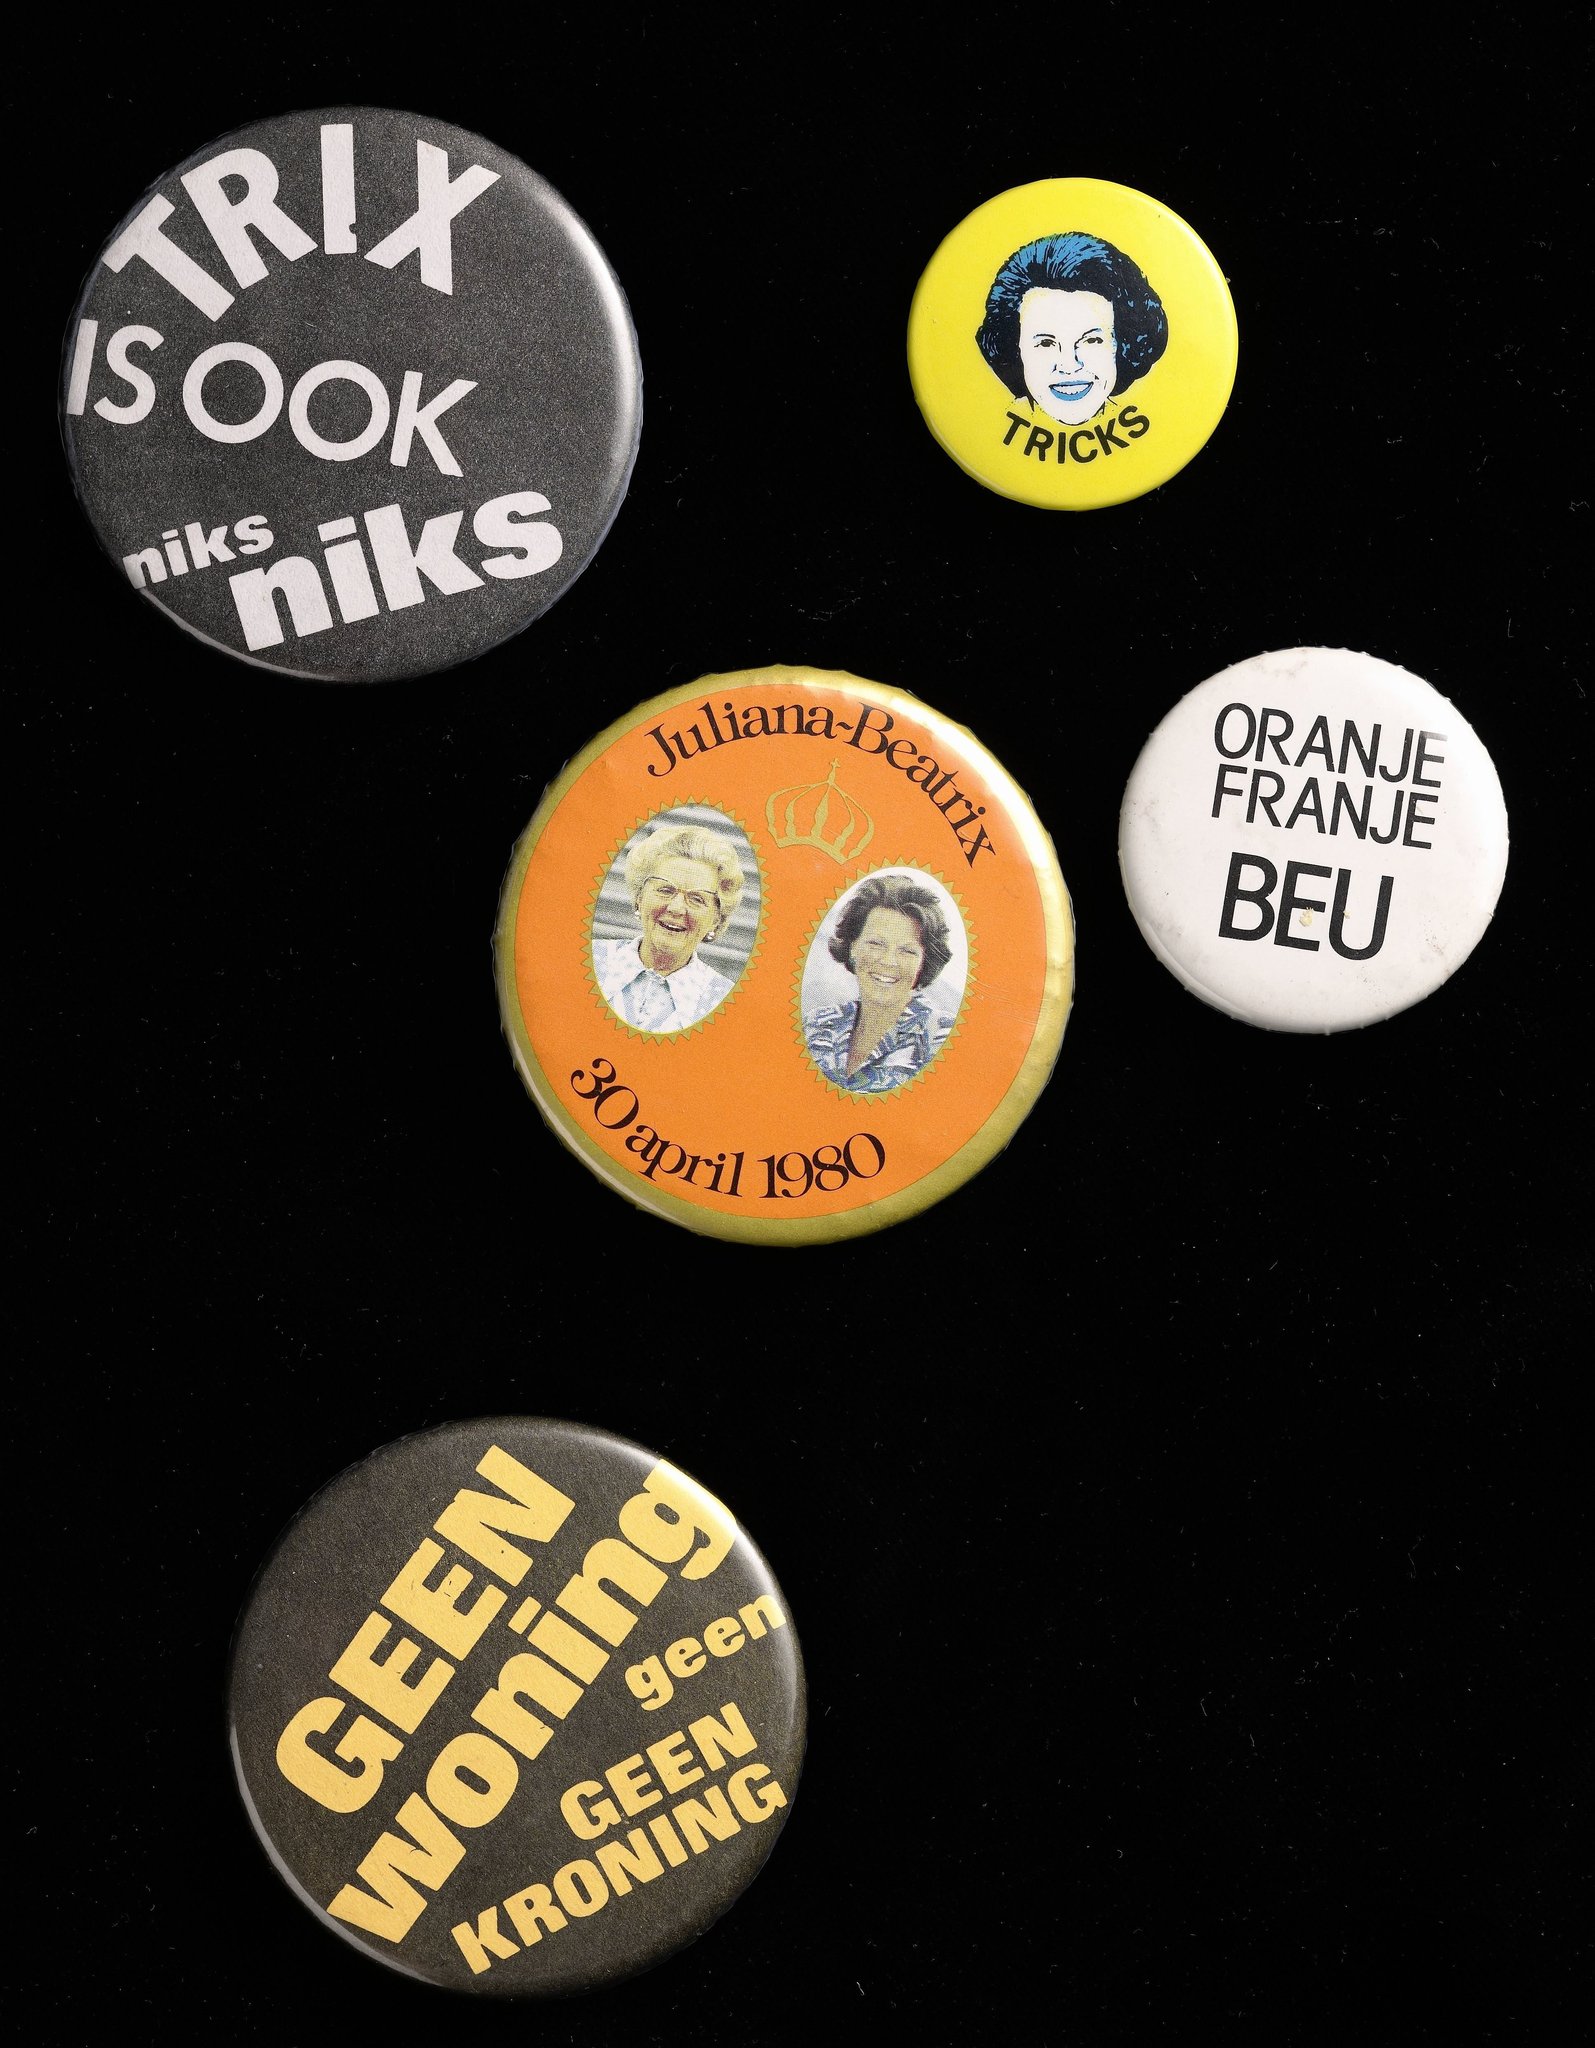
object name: button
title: Button met als tekst: Oranje franje beu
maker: Anonymous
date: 1980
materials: copper, metal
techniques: printing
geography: netherlands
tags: beatrix (koningin der nederlanden), the hague, juliana of the netherlands, netherlands, inauguration of beatrix as queen of the netherlands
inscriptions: inscription: ‘ORANJE FRANJE BEU’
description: Witte button met zwarte tekst. Achterzijde button is voorzien van een speld.